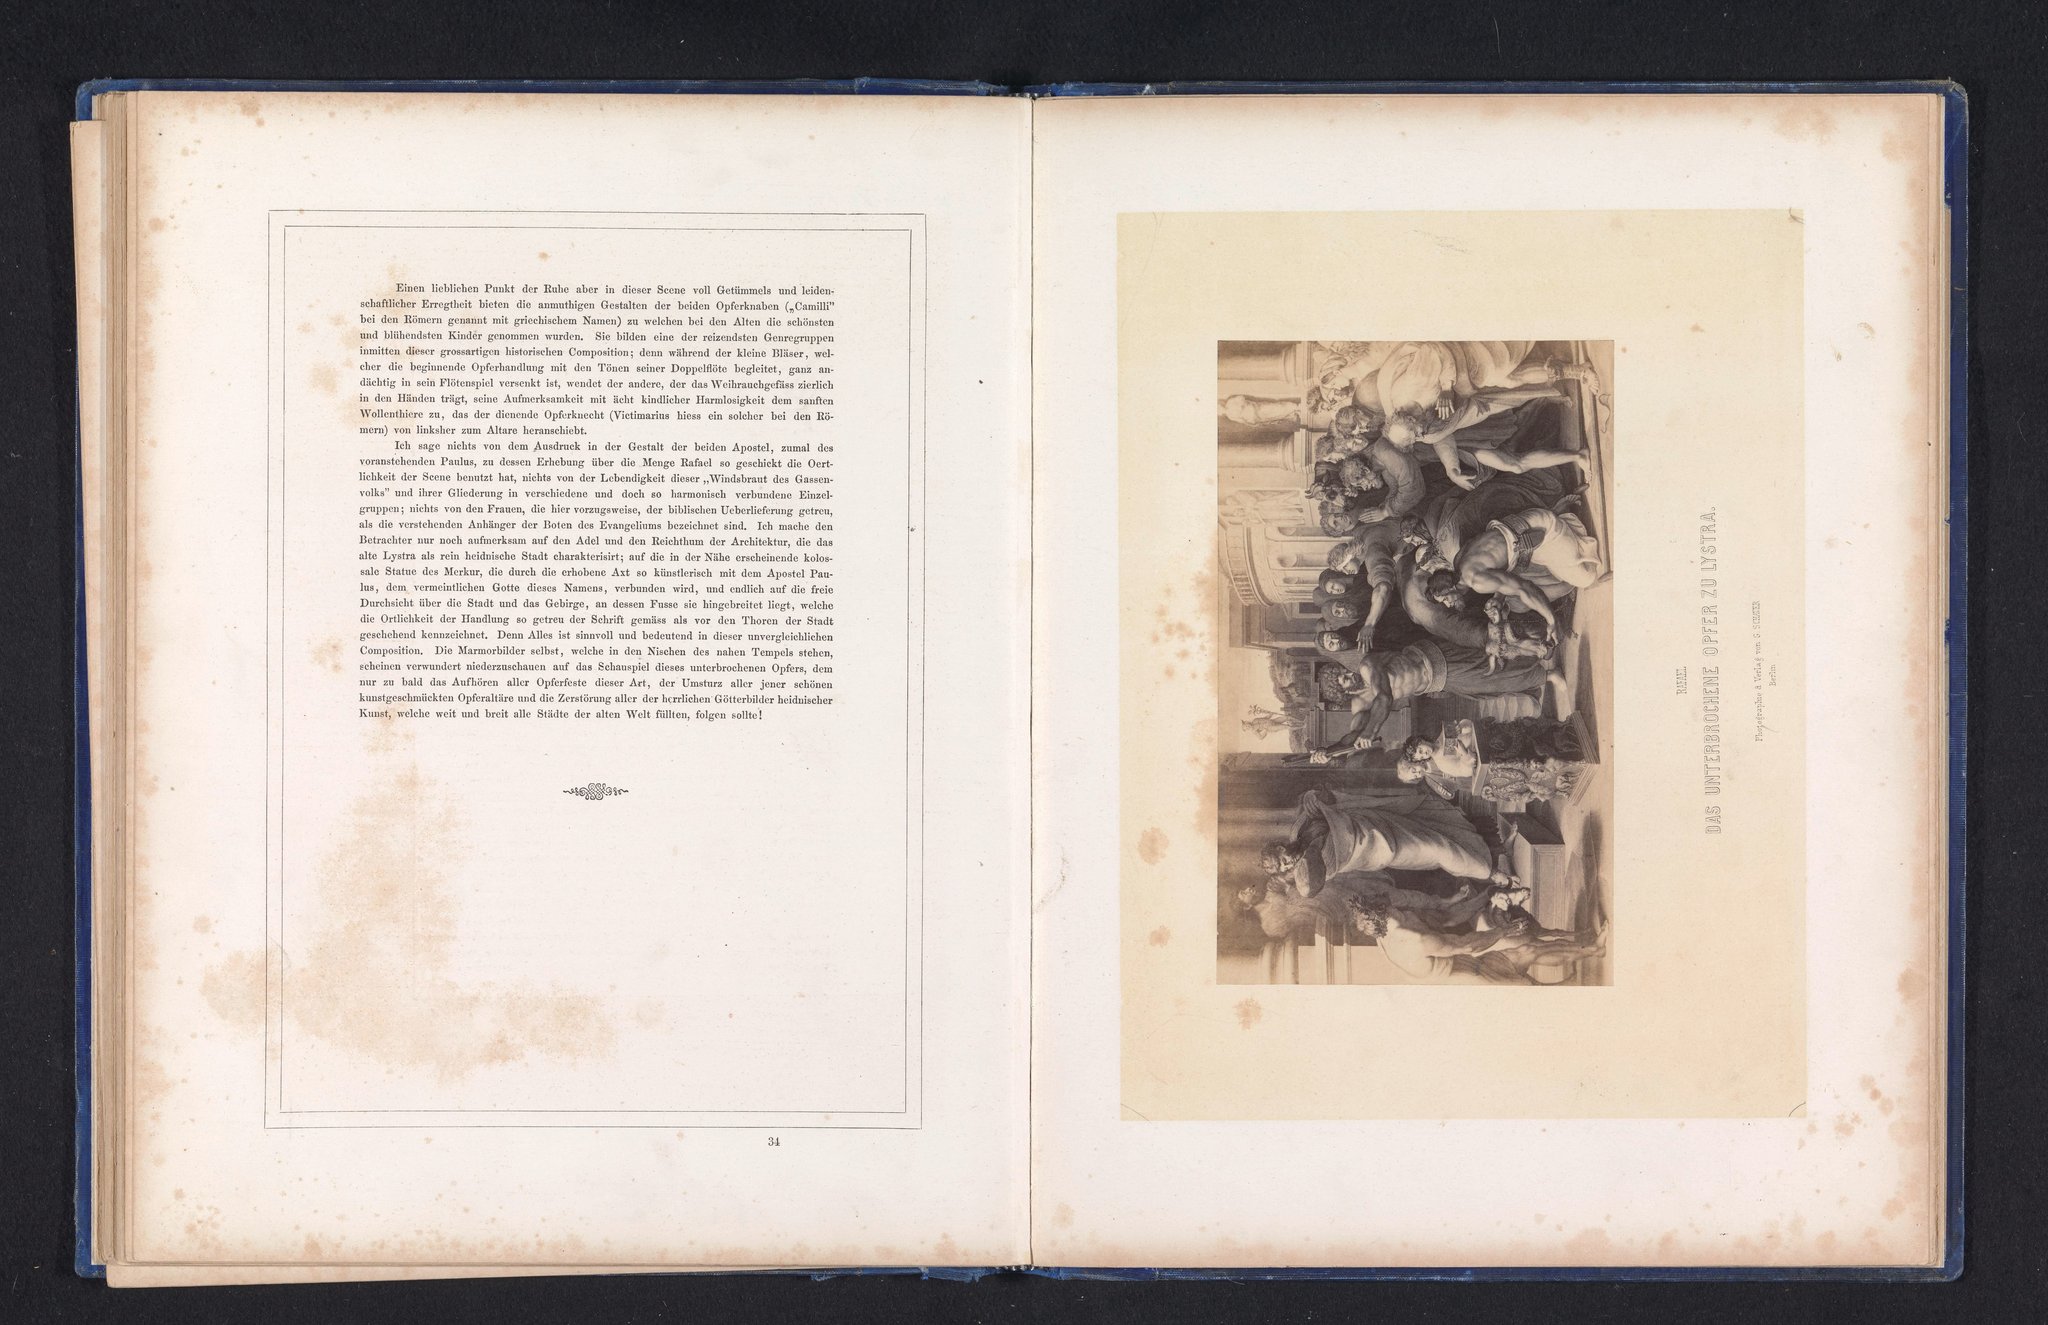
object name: photograph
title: Fotoreproductie van een prent naar een karton voor een tapijt door Rafaël, voorstellend een offer te Lystra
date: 1851-1861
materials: photographic support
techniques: albumen print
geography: berlin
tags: paul and barnabas at lystra